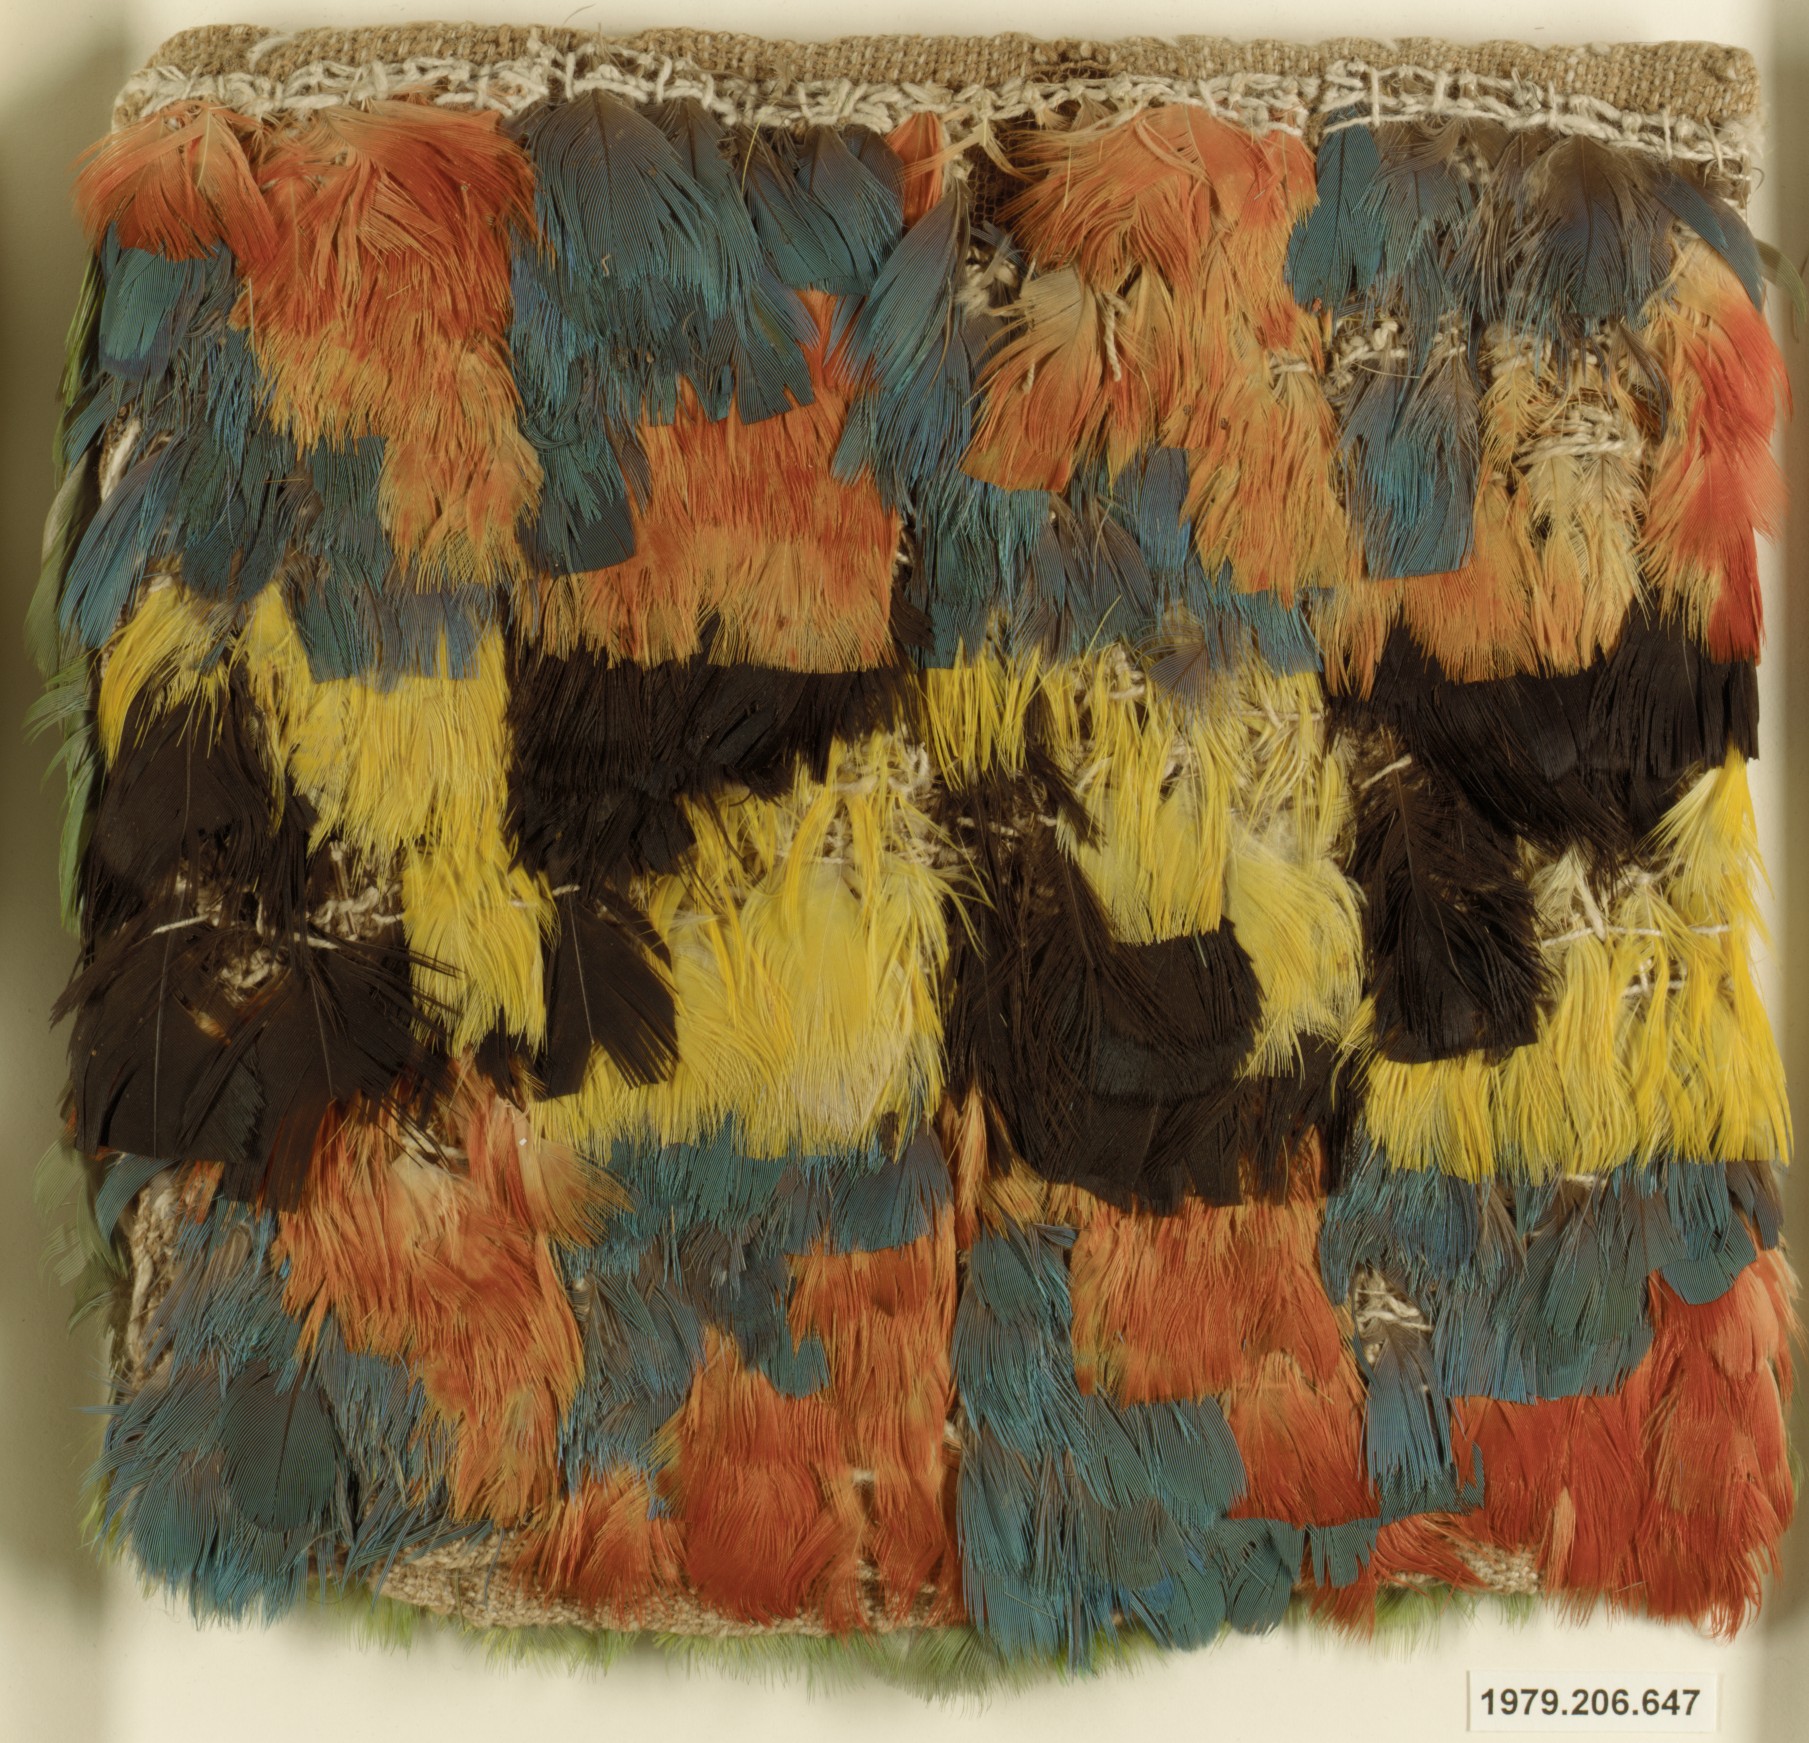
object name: miniature dress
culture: ica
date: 1101-1300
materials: cotton, feather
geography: peru